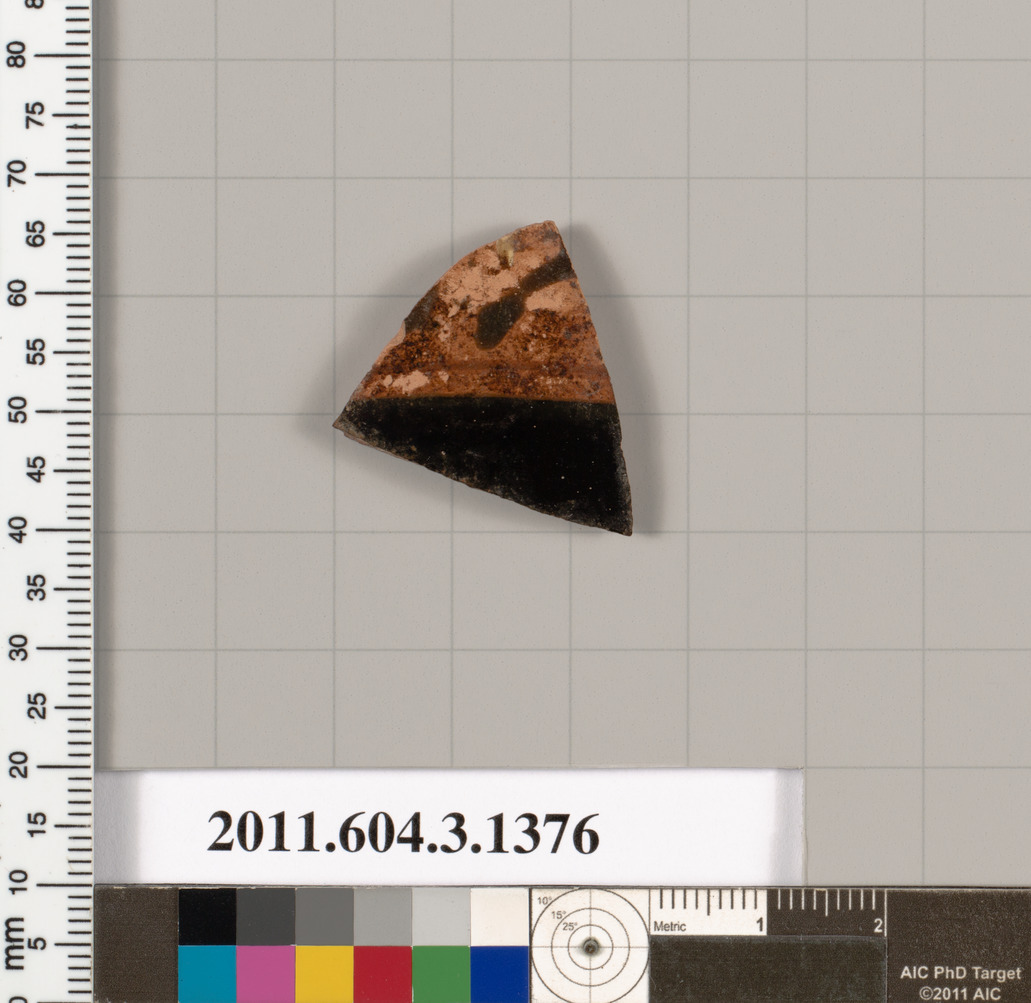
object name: skyphos fragment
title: Terracotta fragment of a skyphos (deep drinking cup)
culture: greek, attic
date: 500-468 BCE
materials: terracotta